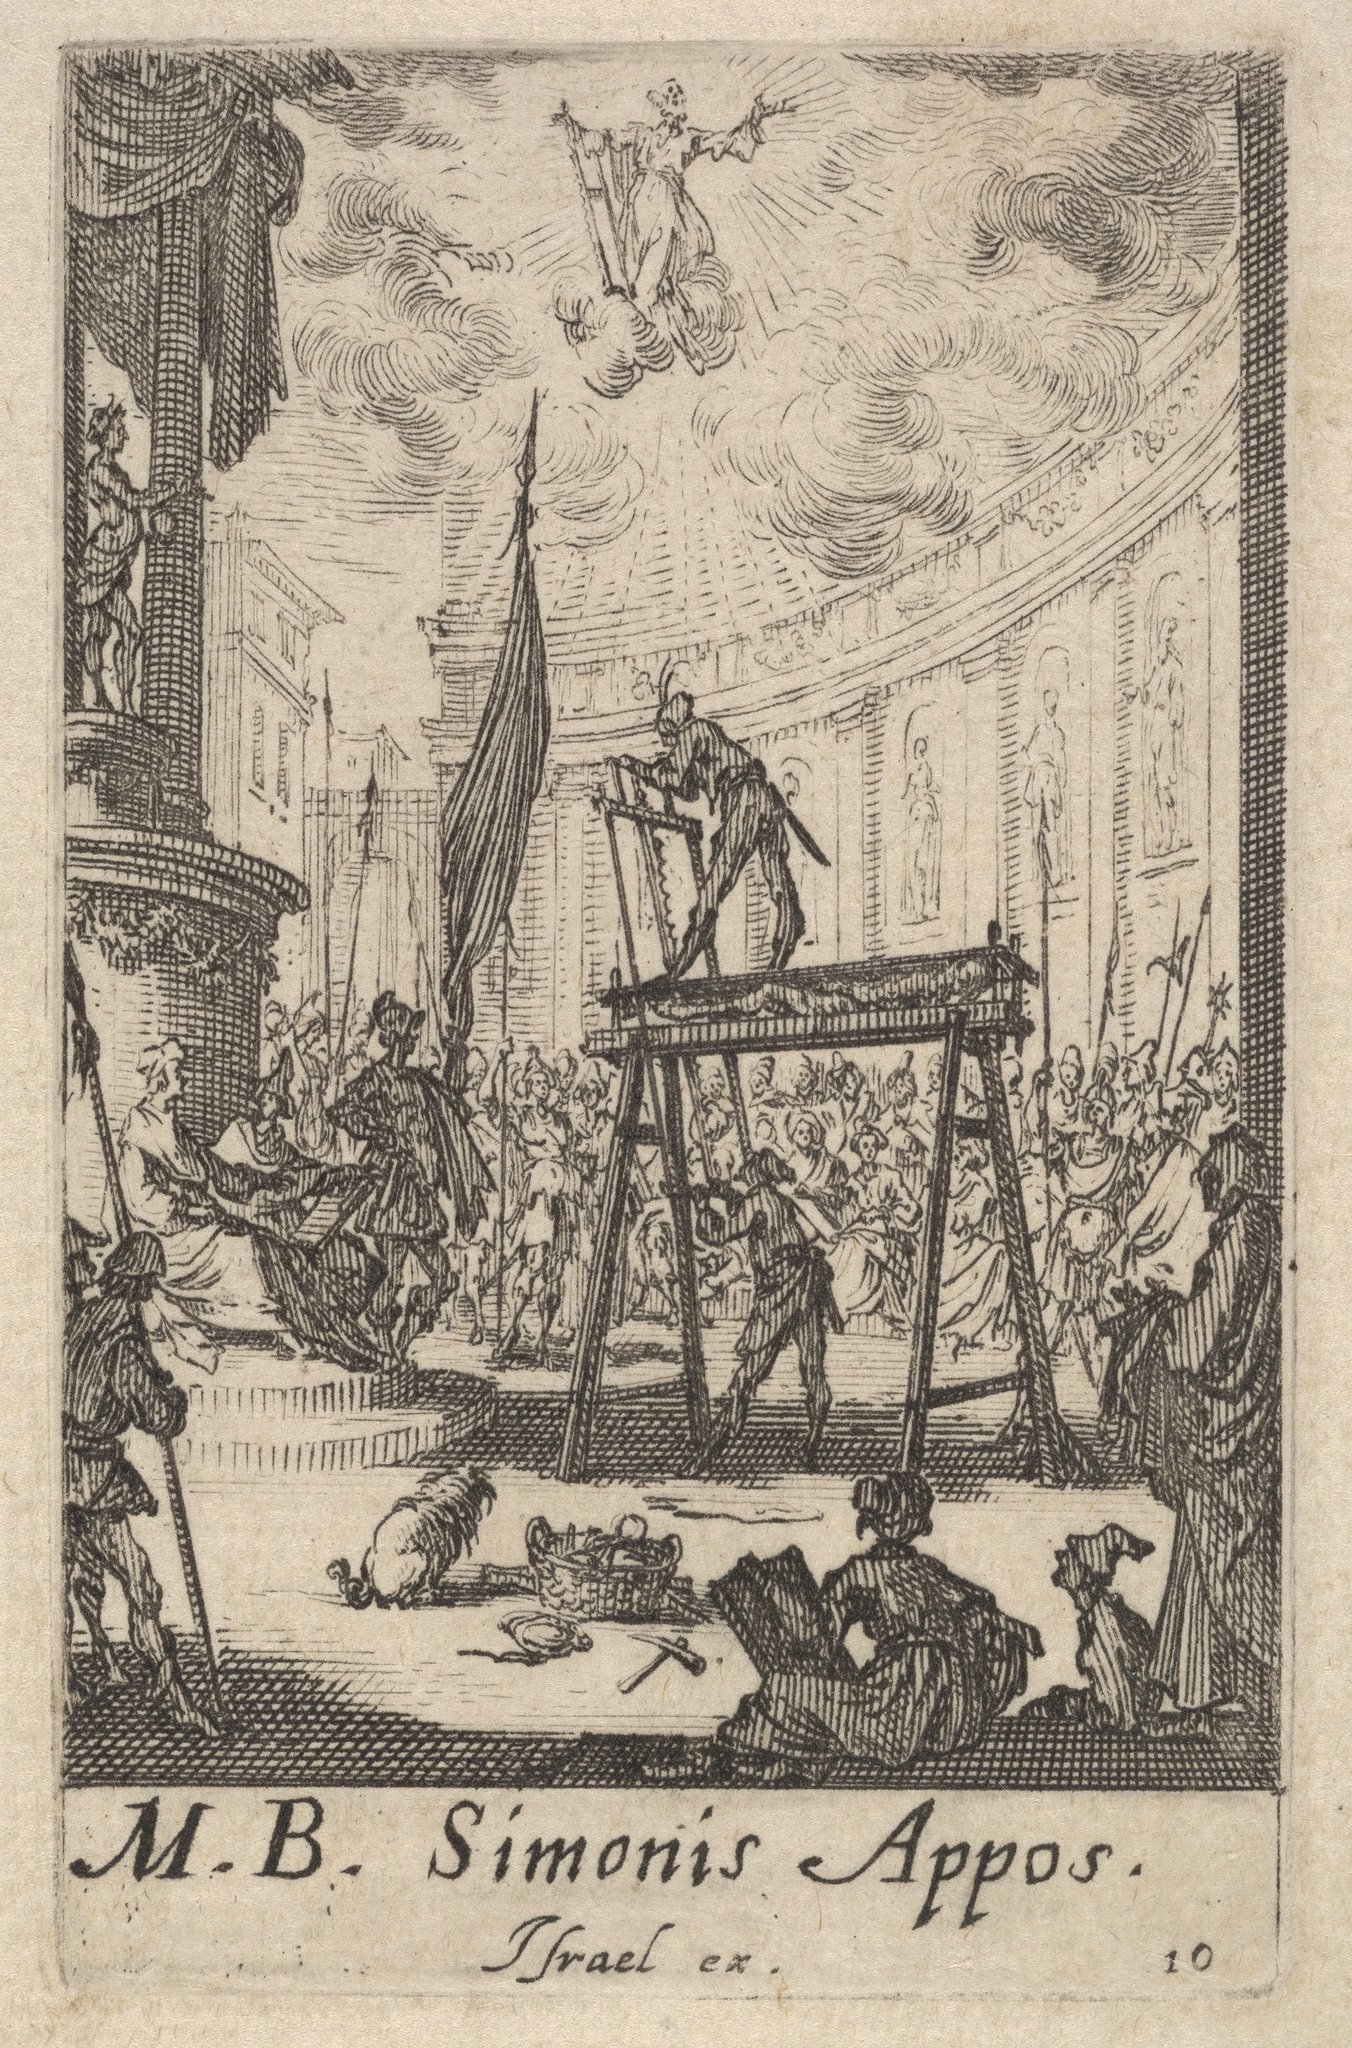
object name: print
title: Martyrdom of Saint Simon, from "The Little Apostles" (Les Petits Apôtres)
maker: jacques callot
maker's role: artist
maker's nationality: french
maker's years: 1592-1635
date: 1632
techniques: etching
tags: animals,men,angels,saints